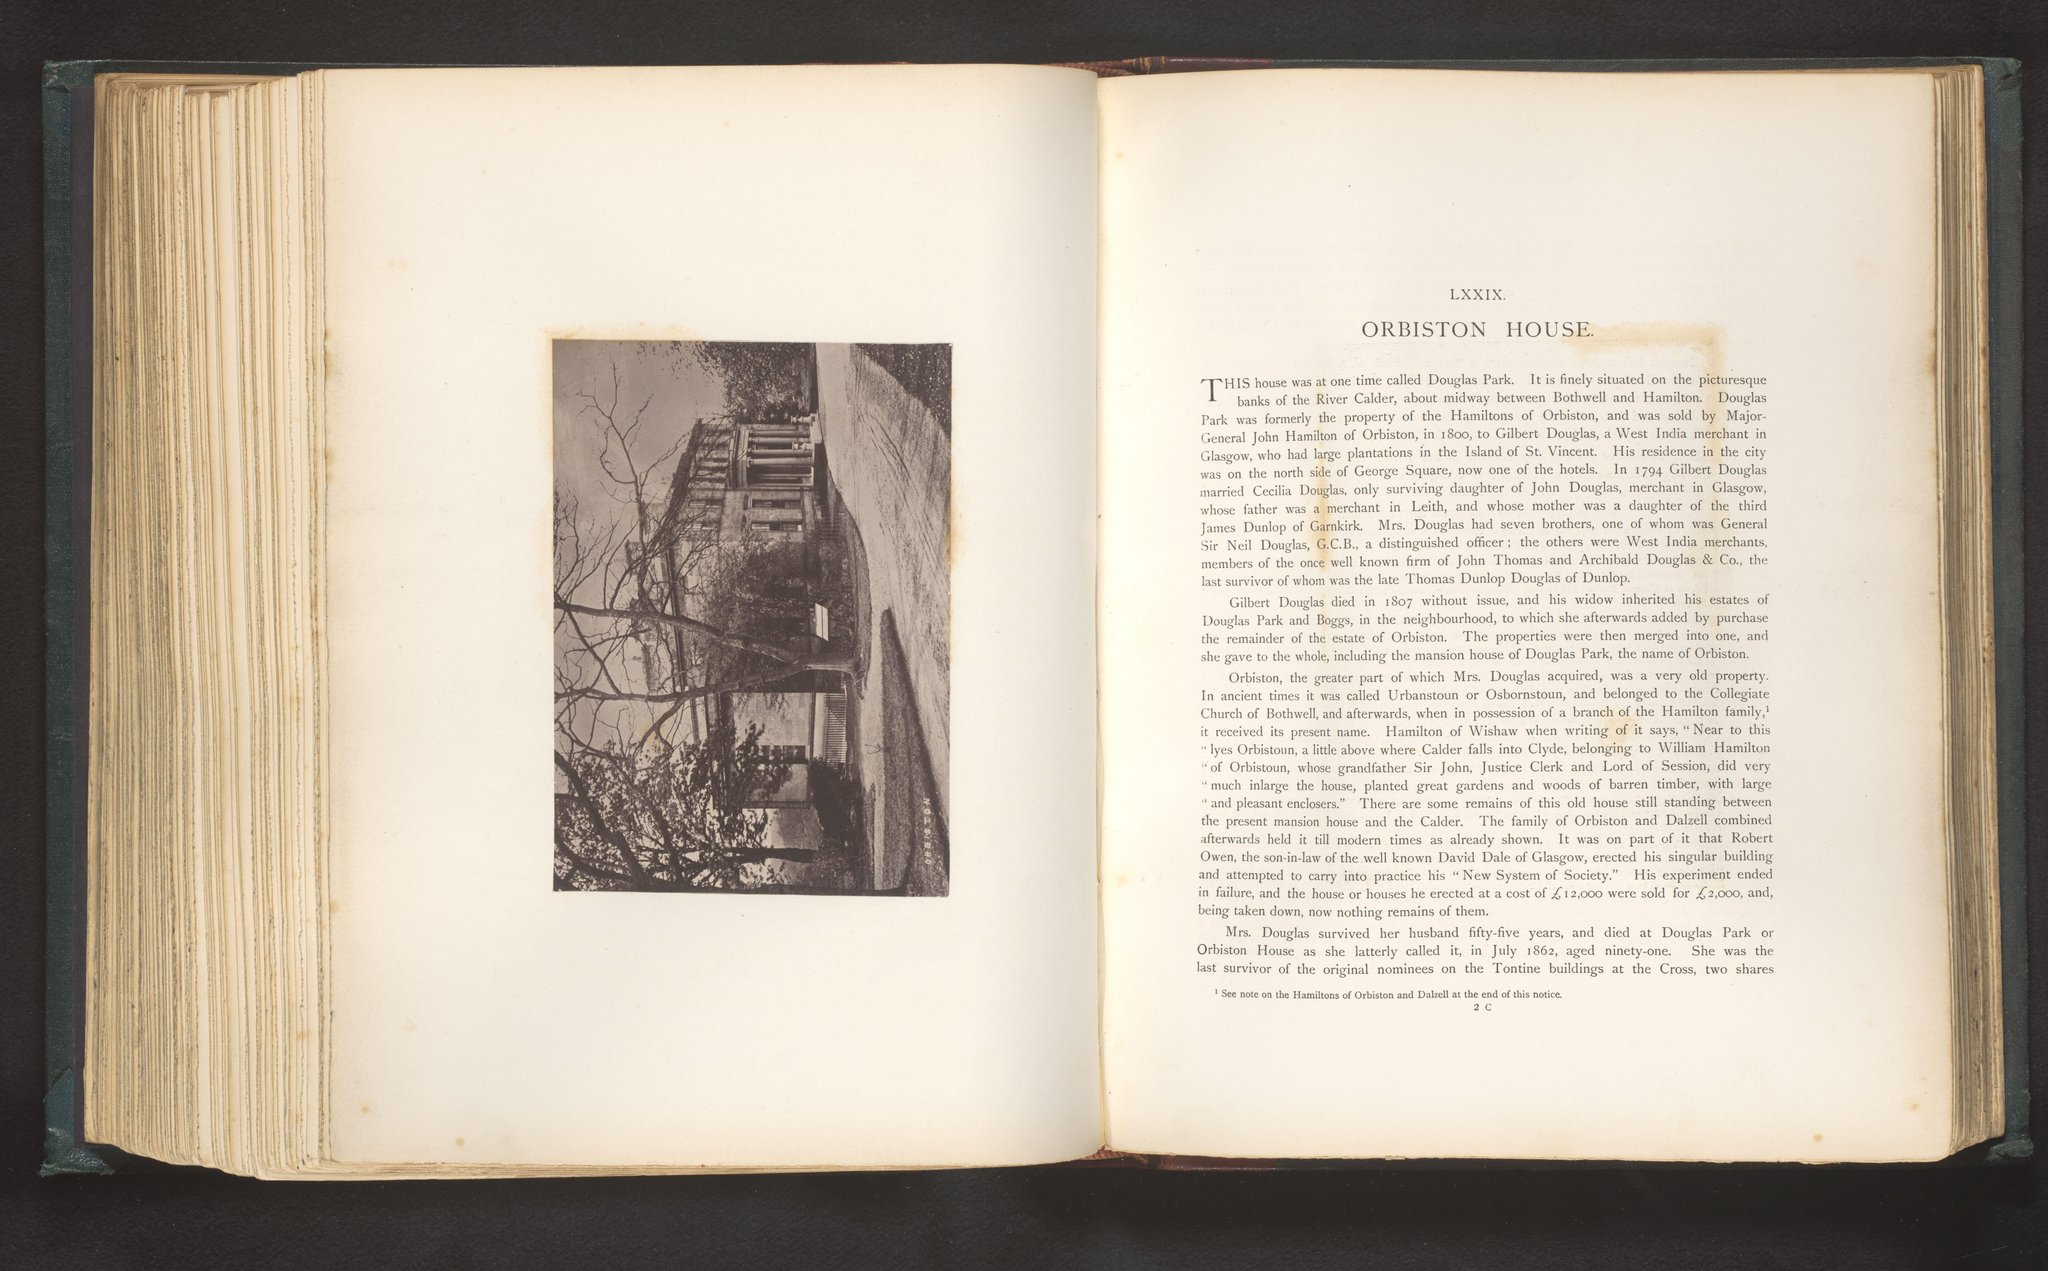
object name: page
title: Orbiston House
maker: thomas annan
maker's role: fotograaf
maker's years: 1829-1887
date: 1868-1878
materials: paper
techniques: carbon print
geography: scotland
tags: rural housing, e.g. country-house, villa, cottage, façade (of house or building)